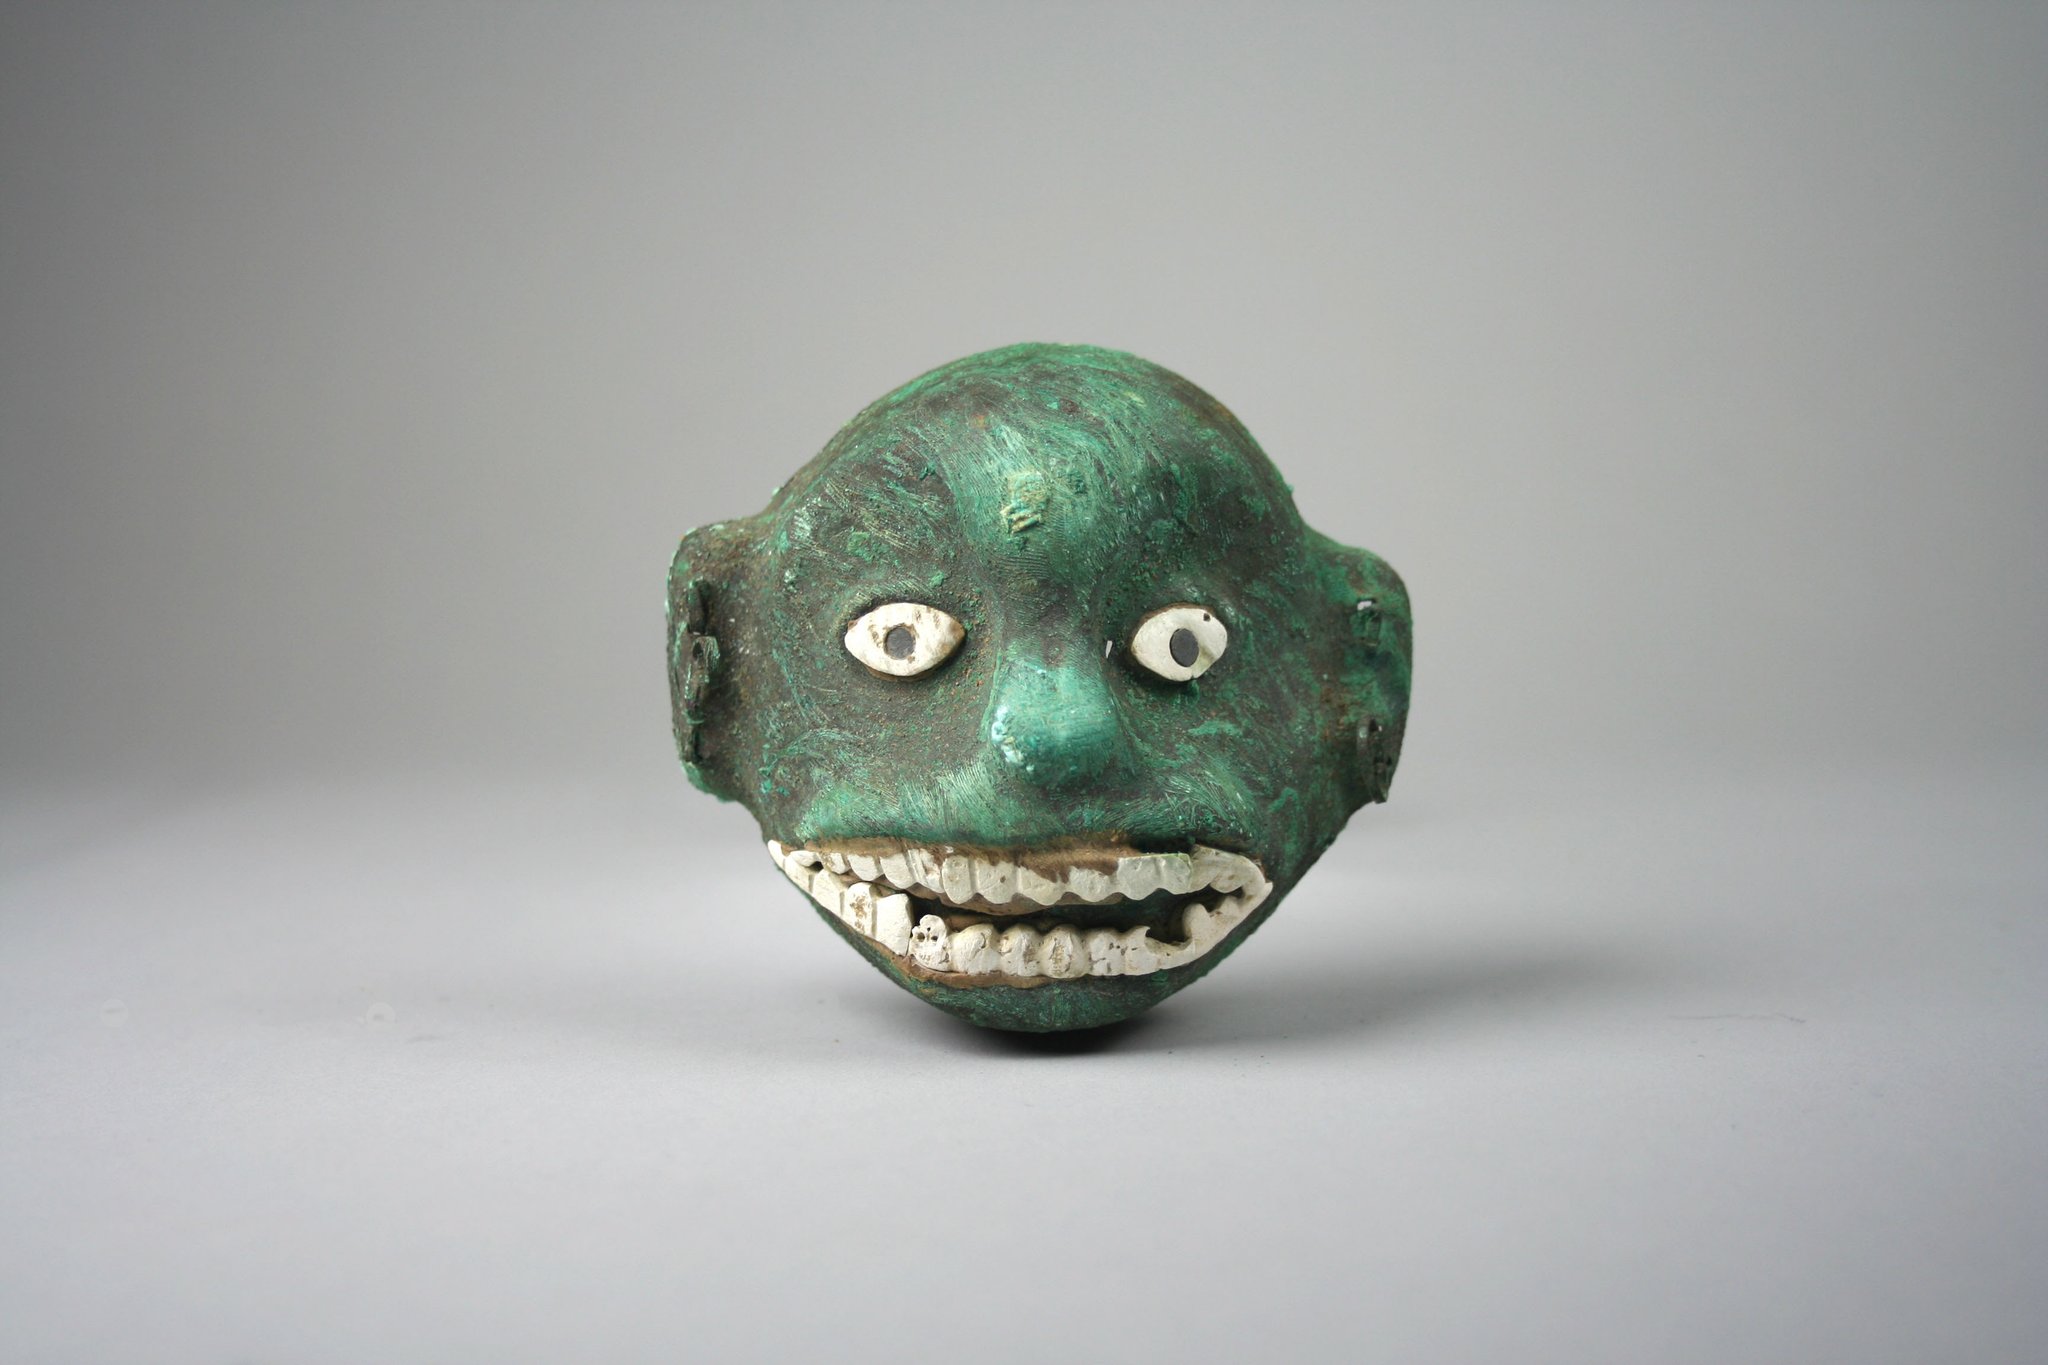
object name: ornament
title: Face Mask Ornament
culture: moche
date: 501-700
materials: feather, gilt copper, shell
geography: peru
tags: faces